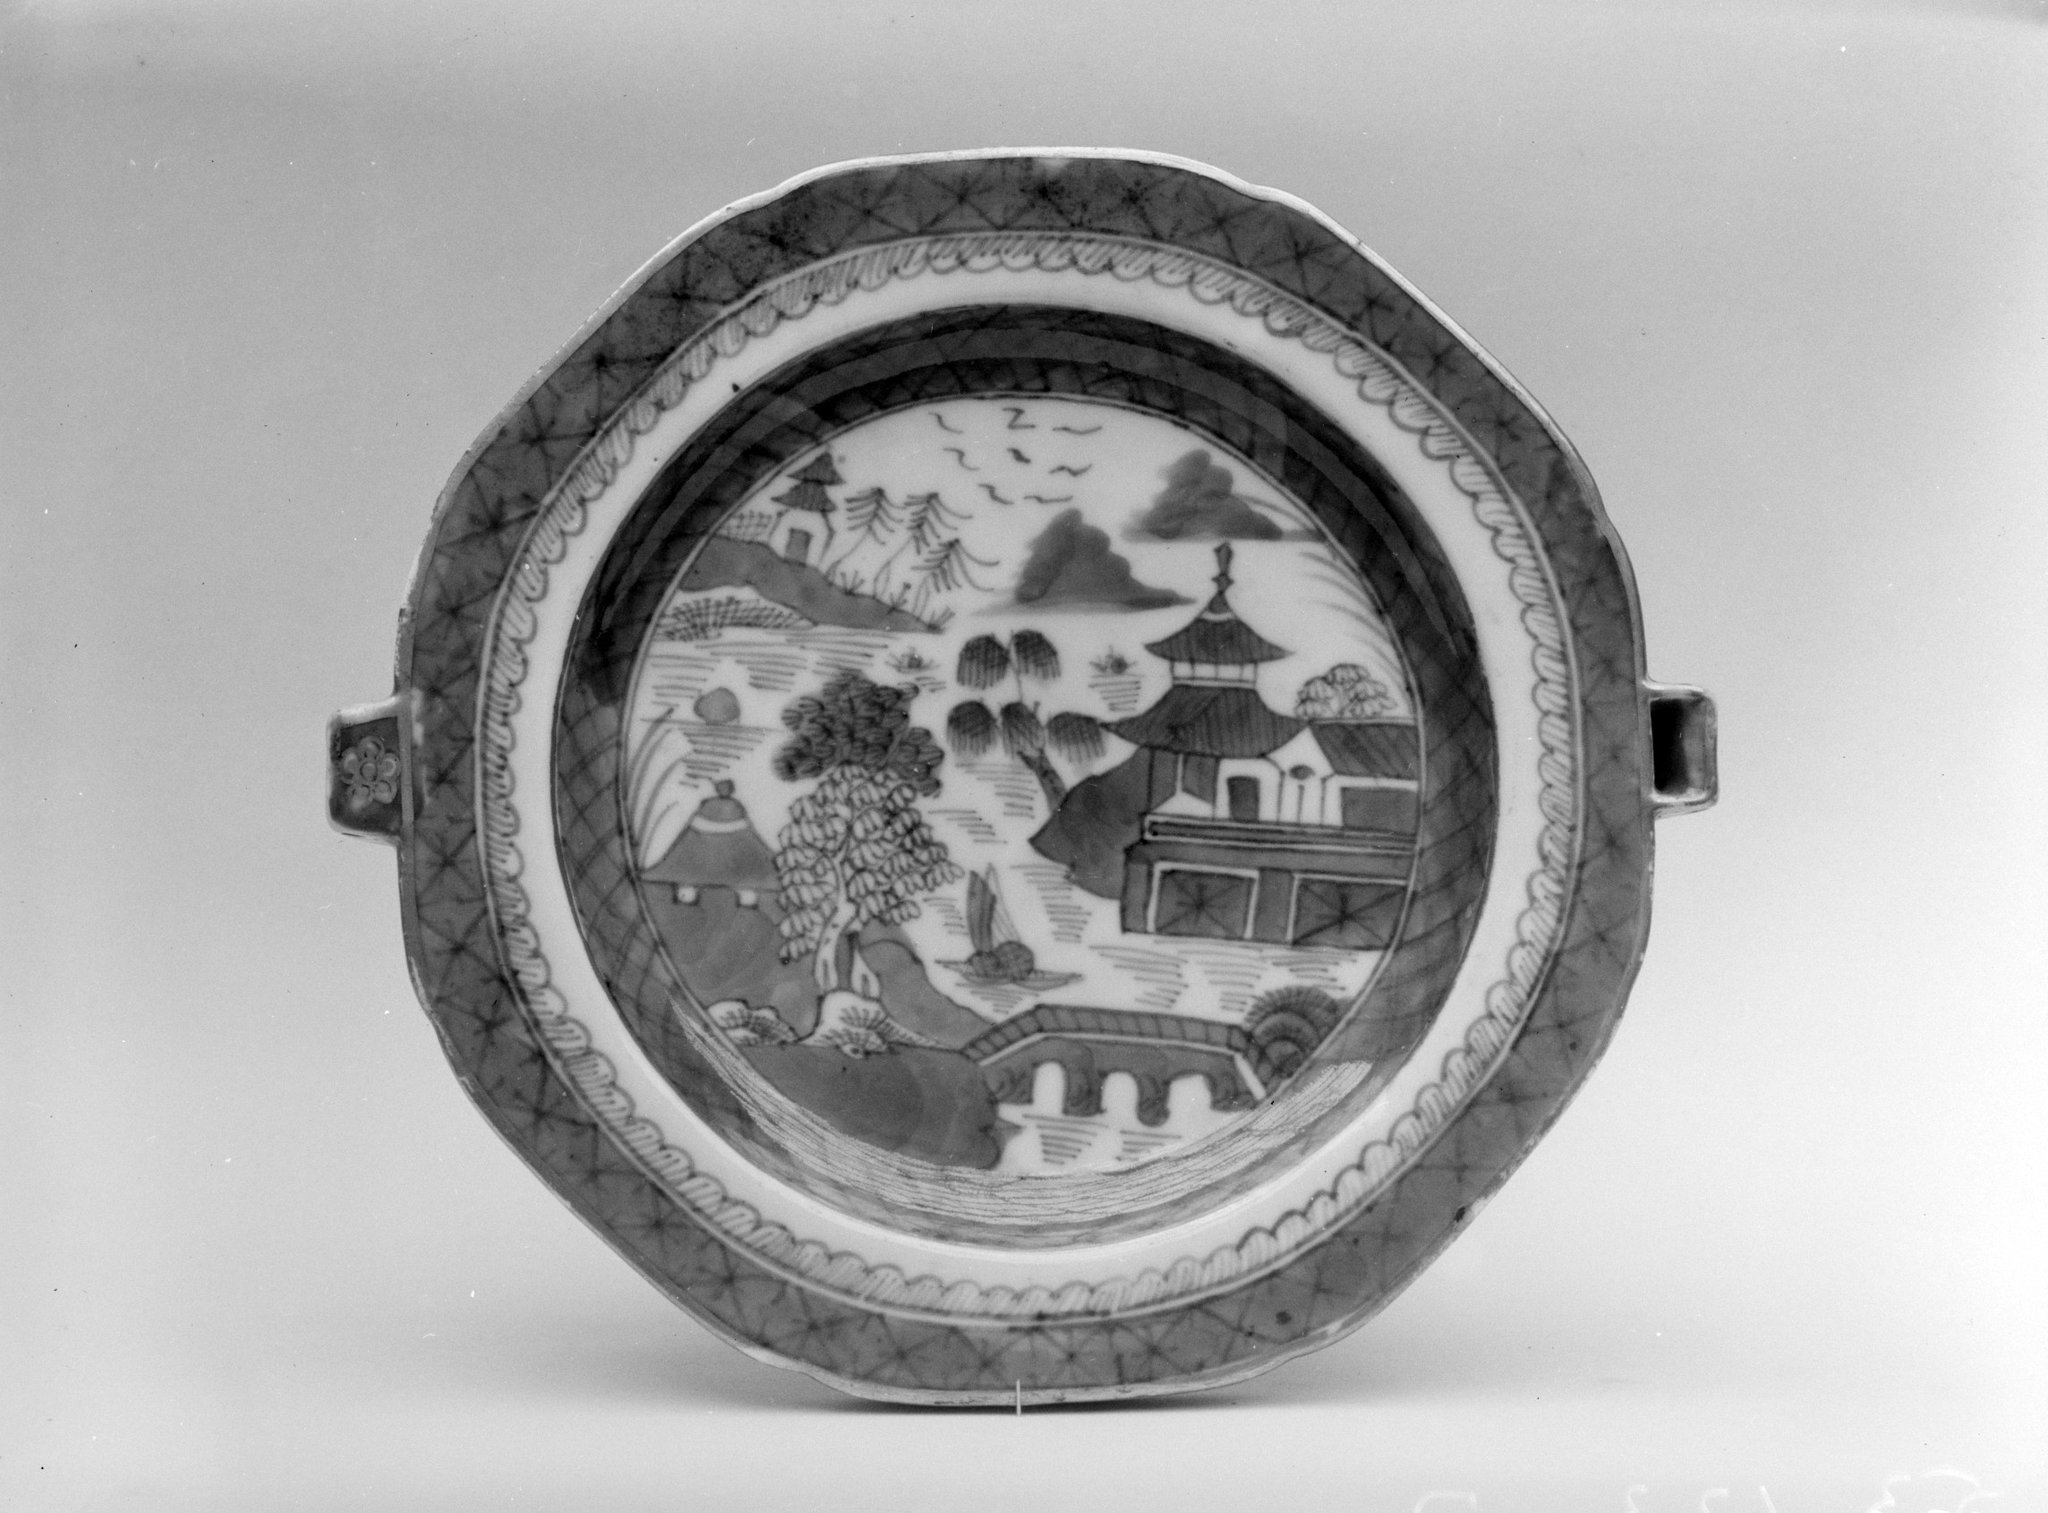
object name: hot water plate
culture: chinese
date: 1800-1830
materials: porcelain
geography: china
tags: landscapes,boats